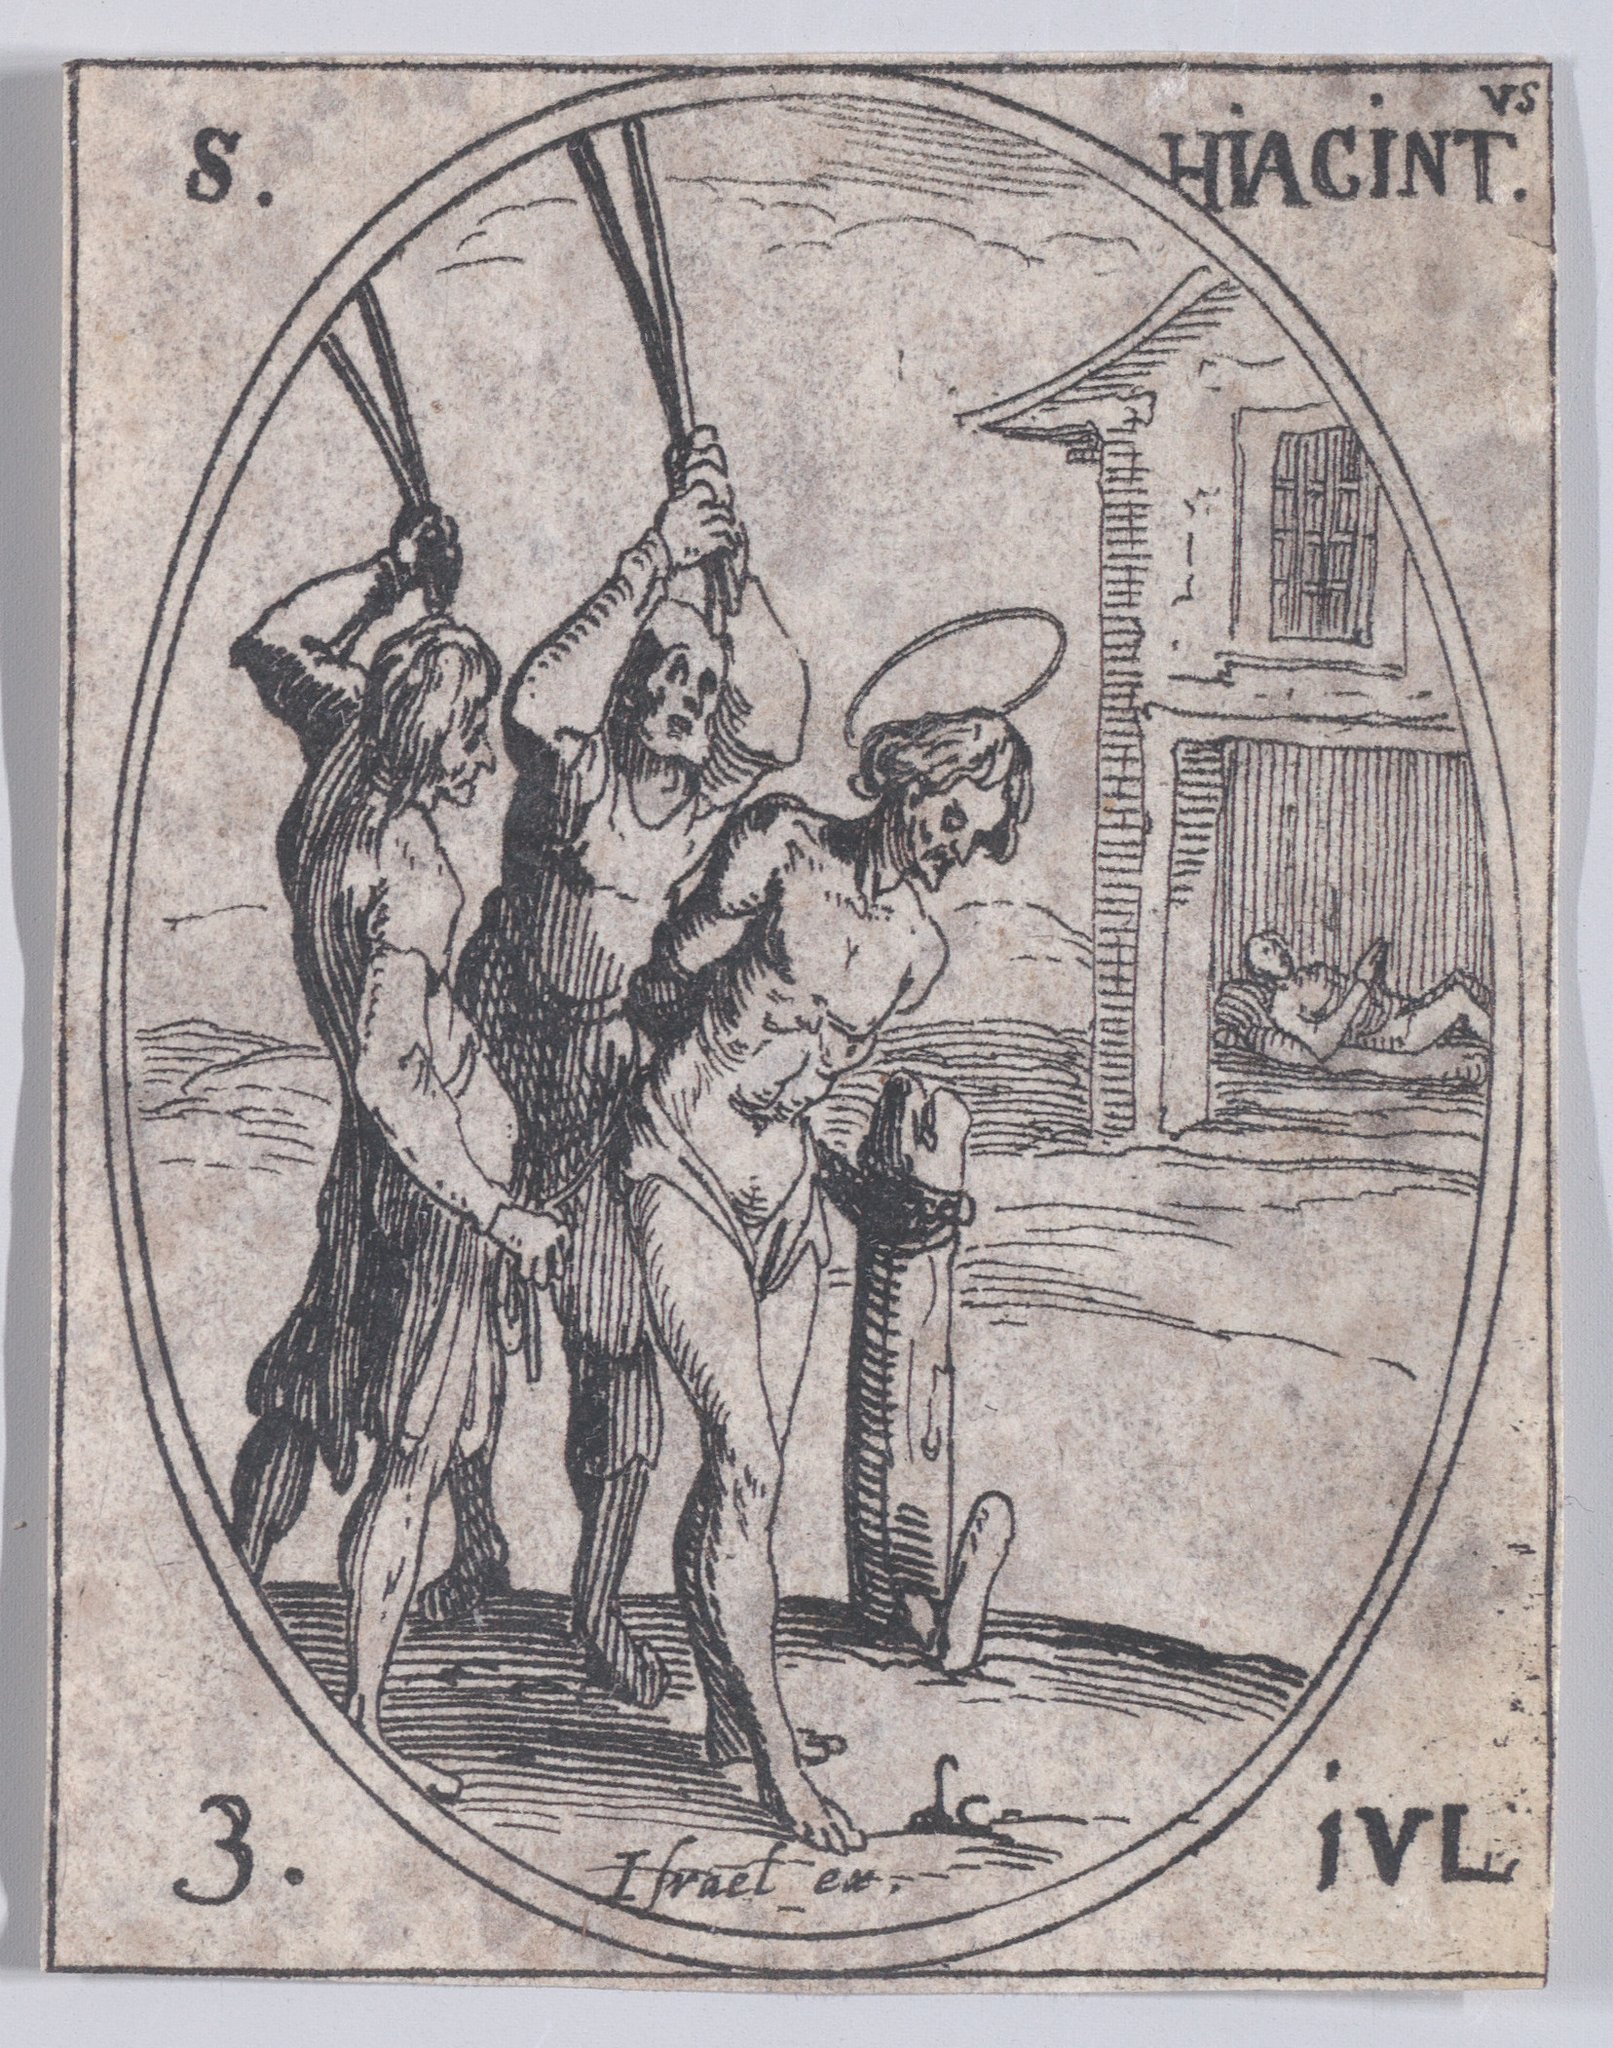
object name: print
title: S. Hiacynthe (St. Hyacinth), July 3rd, from "Les Images De Tous Les Saincts et Saintes de L'Année" (Images of All of the Saints and Religious Events of the Year)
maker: jacques callot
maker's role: artist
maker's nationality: french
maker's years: 1592-1635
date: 1636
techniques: etching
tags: men,saints